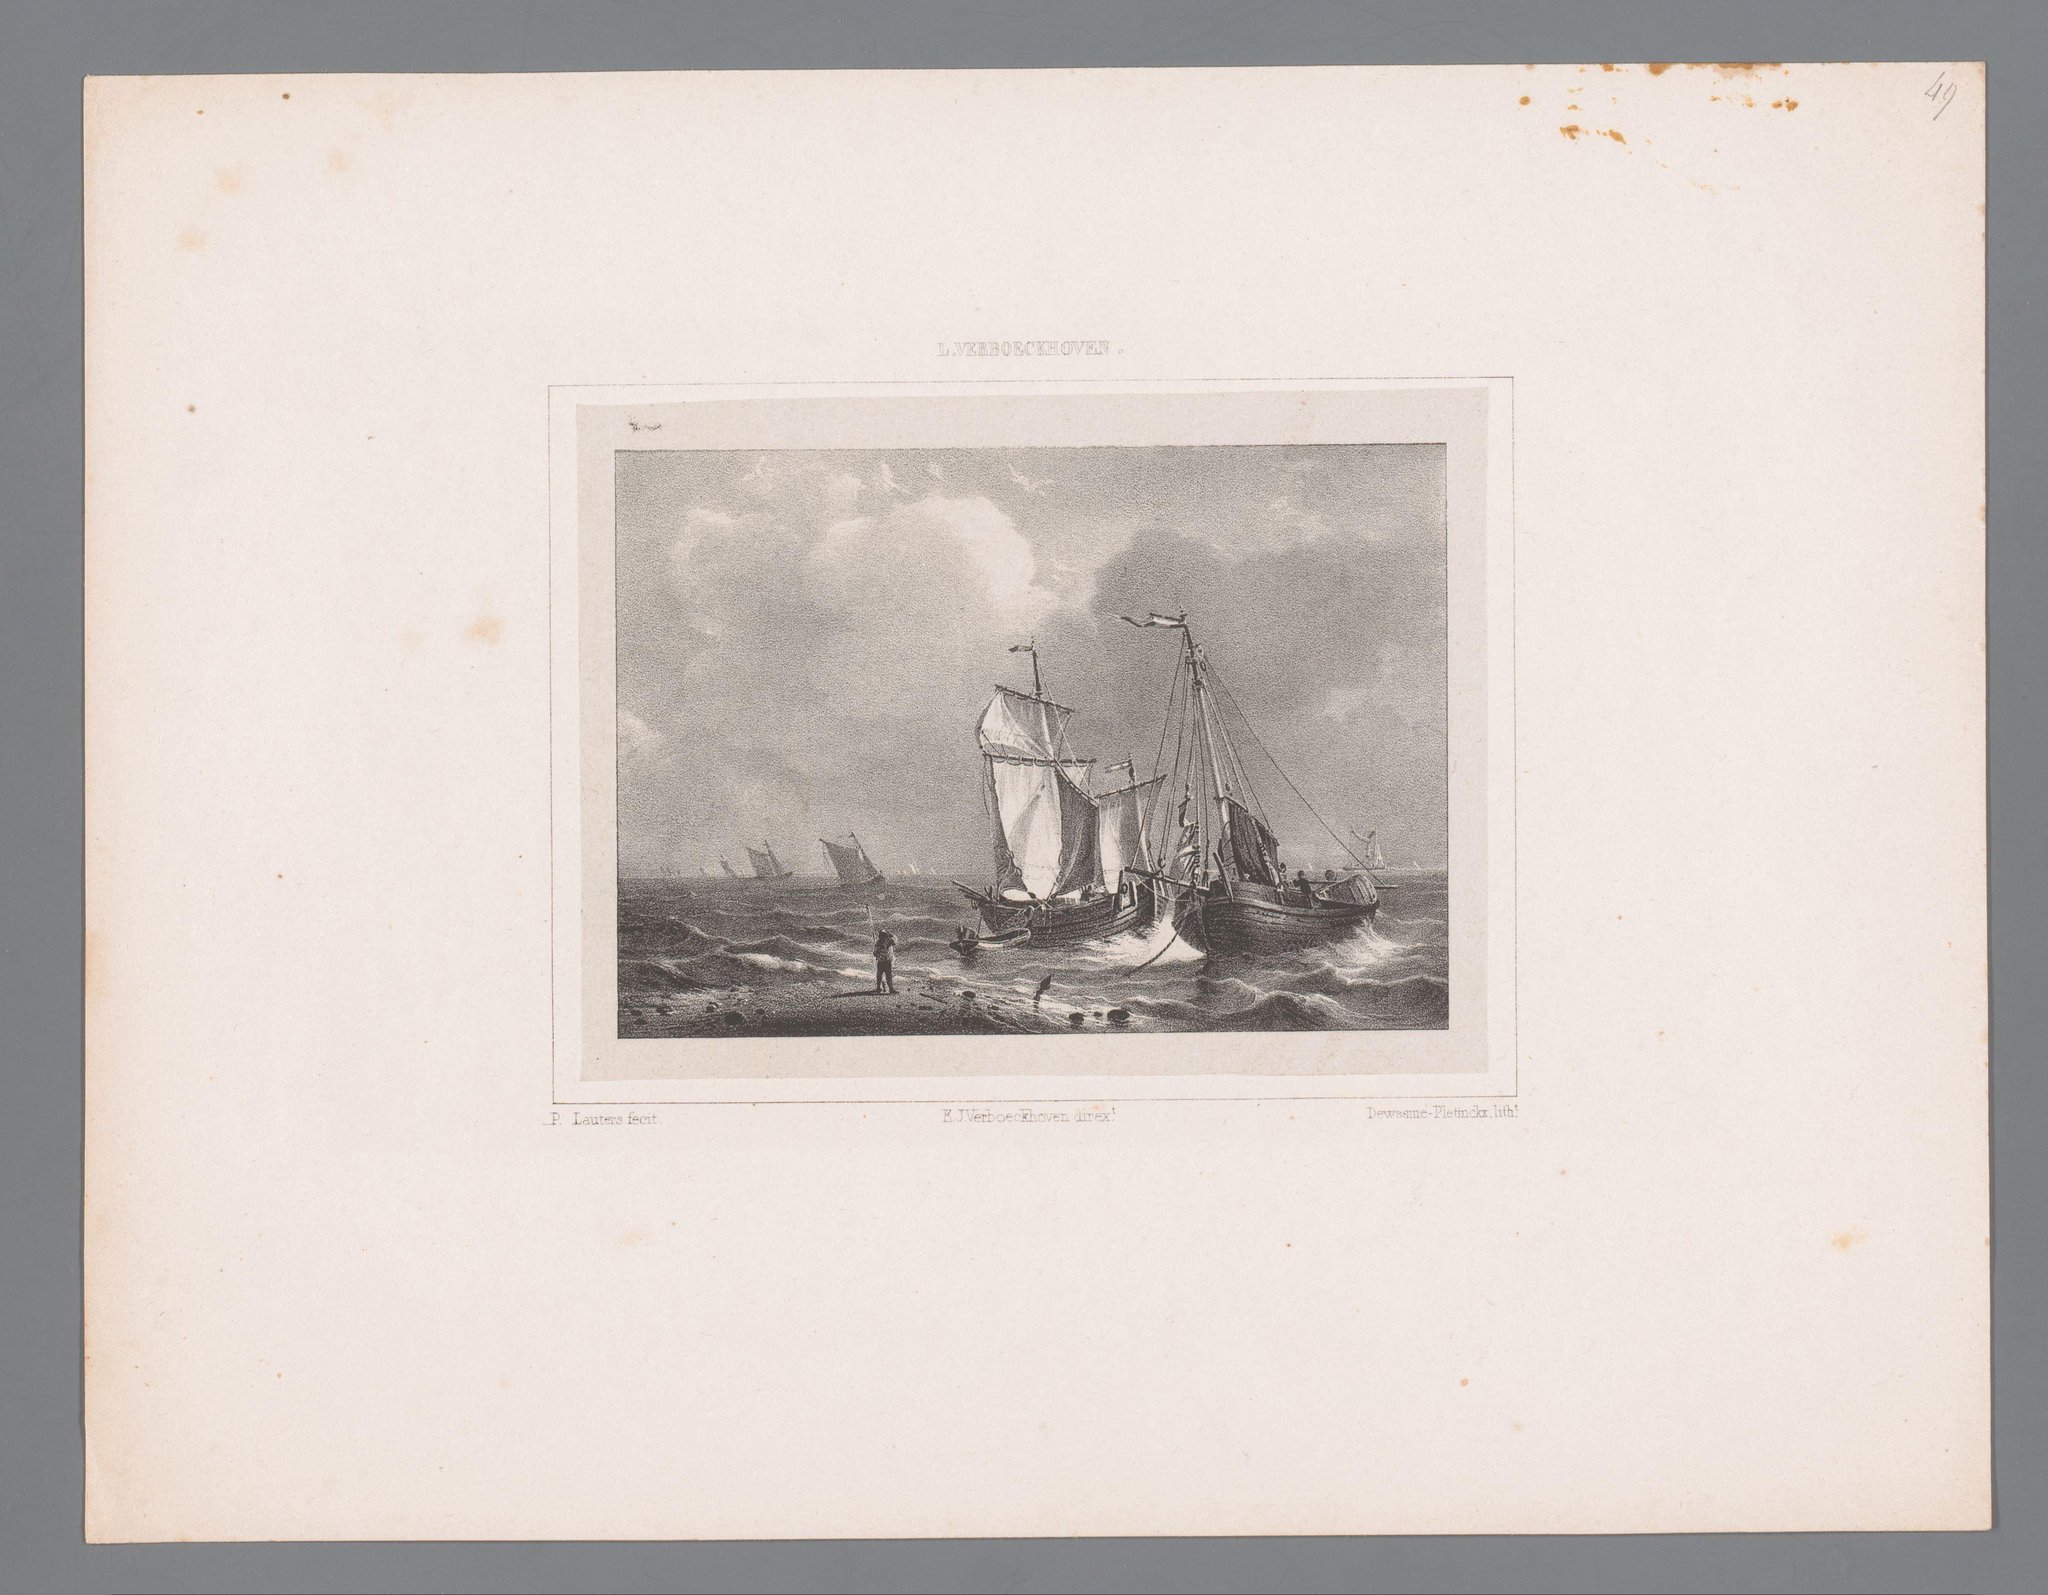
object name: print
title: Lithografieën naar werk van de belangrijkste kunstenaars uit het Verenigd Koninkrijk der Nederlanden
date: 1829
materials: paper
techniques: lithograph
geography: brussels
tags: ships (in general) - cc - more than one ship, coast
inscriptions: collector's mark: Lugt 2233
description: Prent verschenen in: Verboeckhoven, Eugène. Album lithographié par Paul Lauters d'après les dessins des principaux peintres du Royaume des Pays-Bas. Brussel: Antoine Dewasme-Pletinckx, 1829.